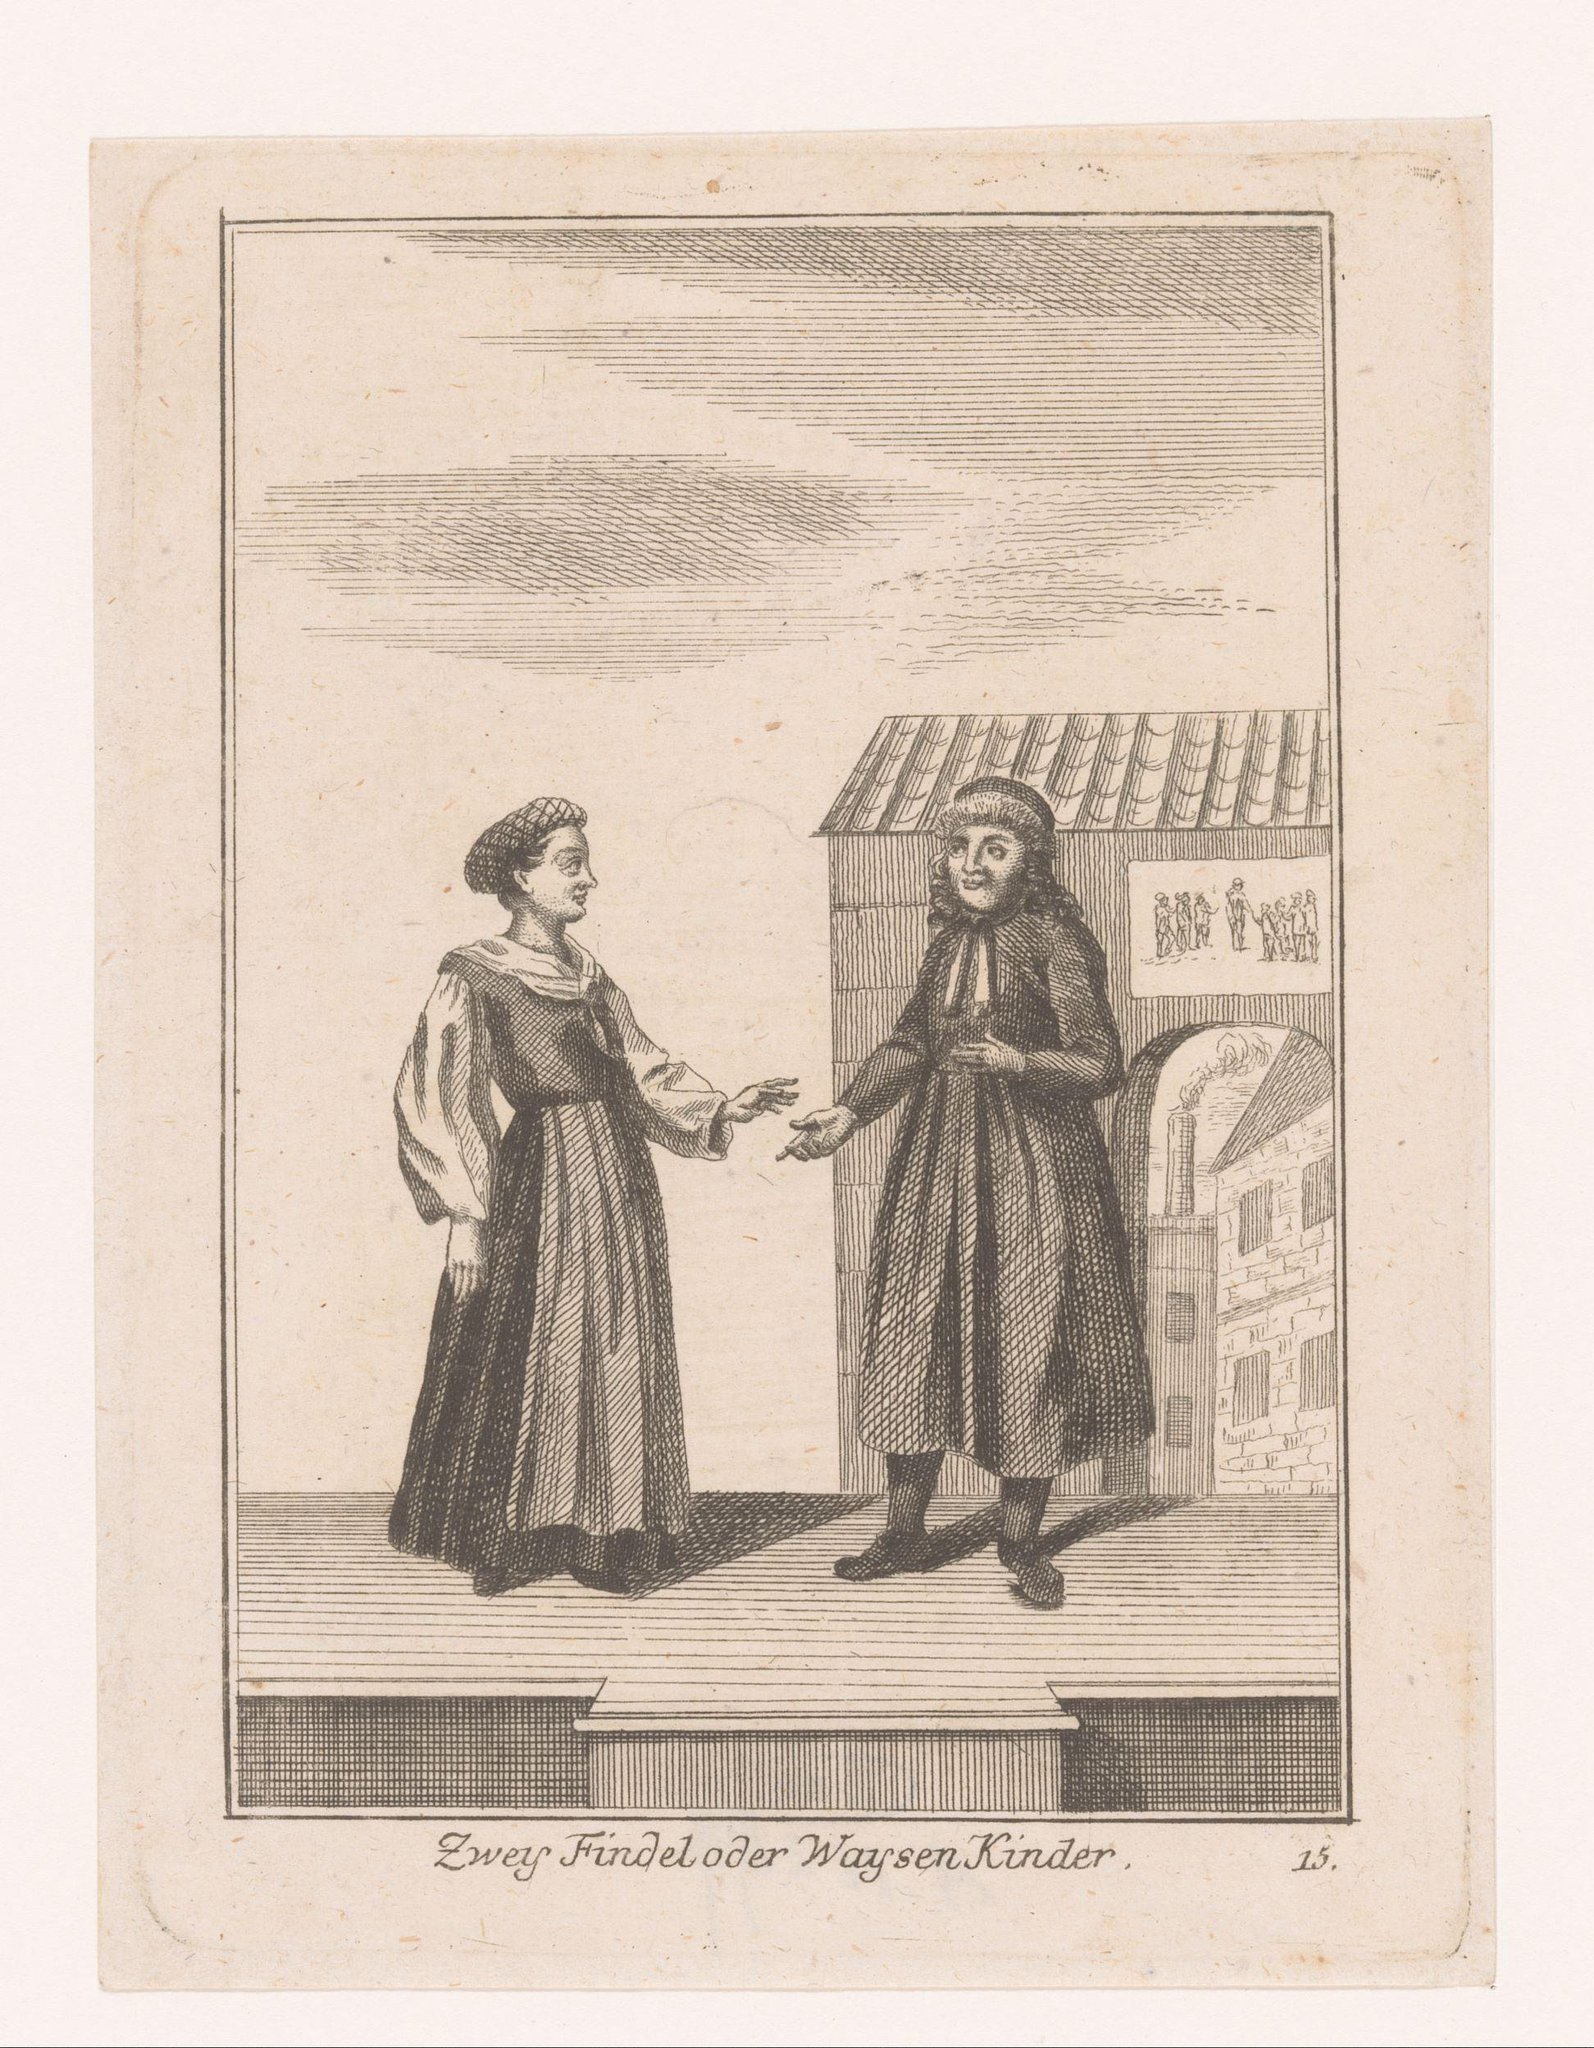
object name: print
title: Zwey Findel oder Waysen Kinder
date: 1797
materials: paper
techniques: engraving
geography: nuremberg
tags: professional clothes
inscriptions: collector's mark: Lugt 2228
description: Onderdeel van een serie met figuren in Neurenbergse kostumen.